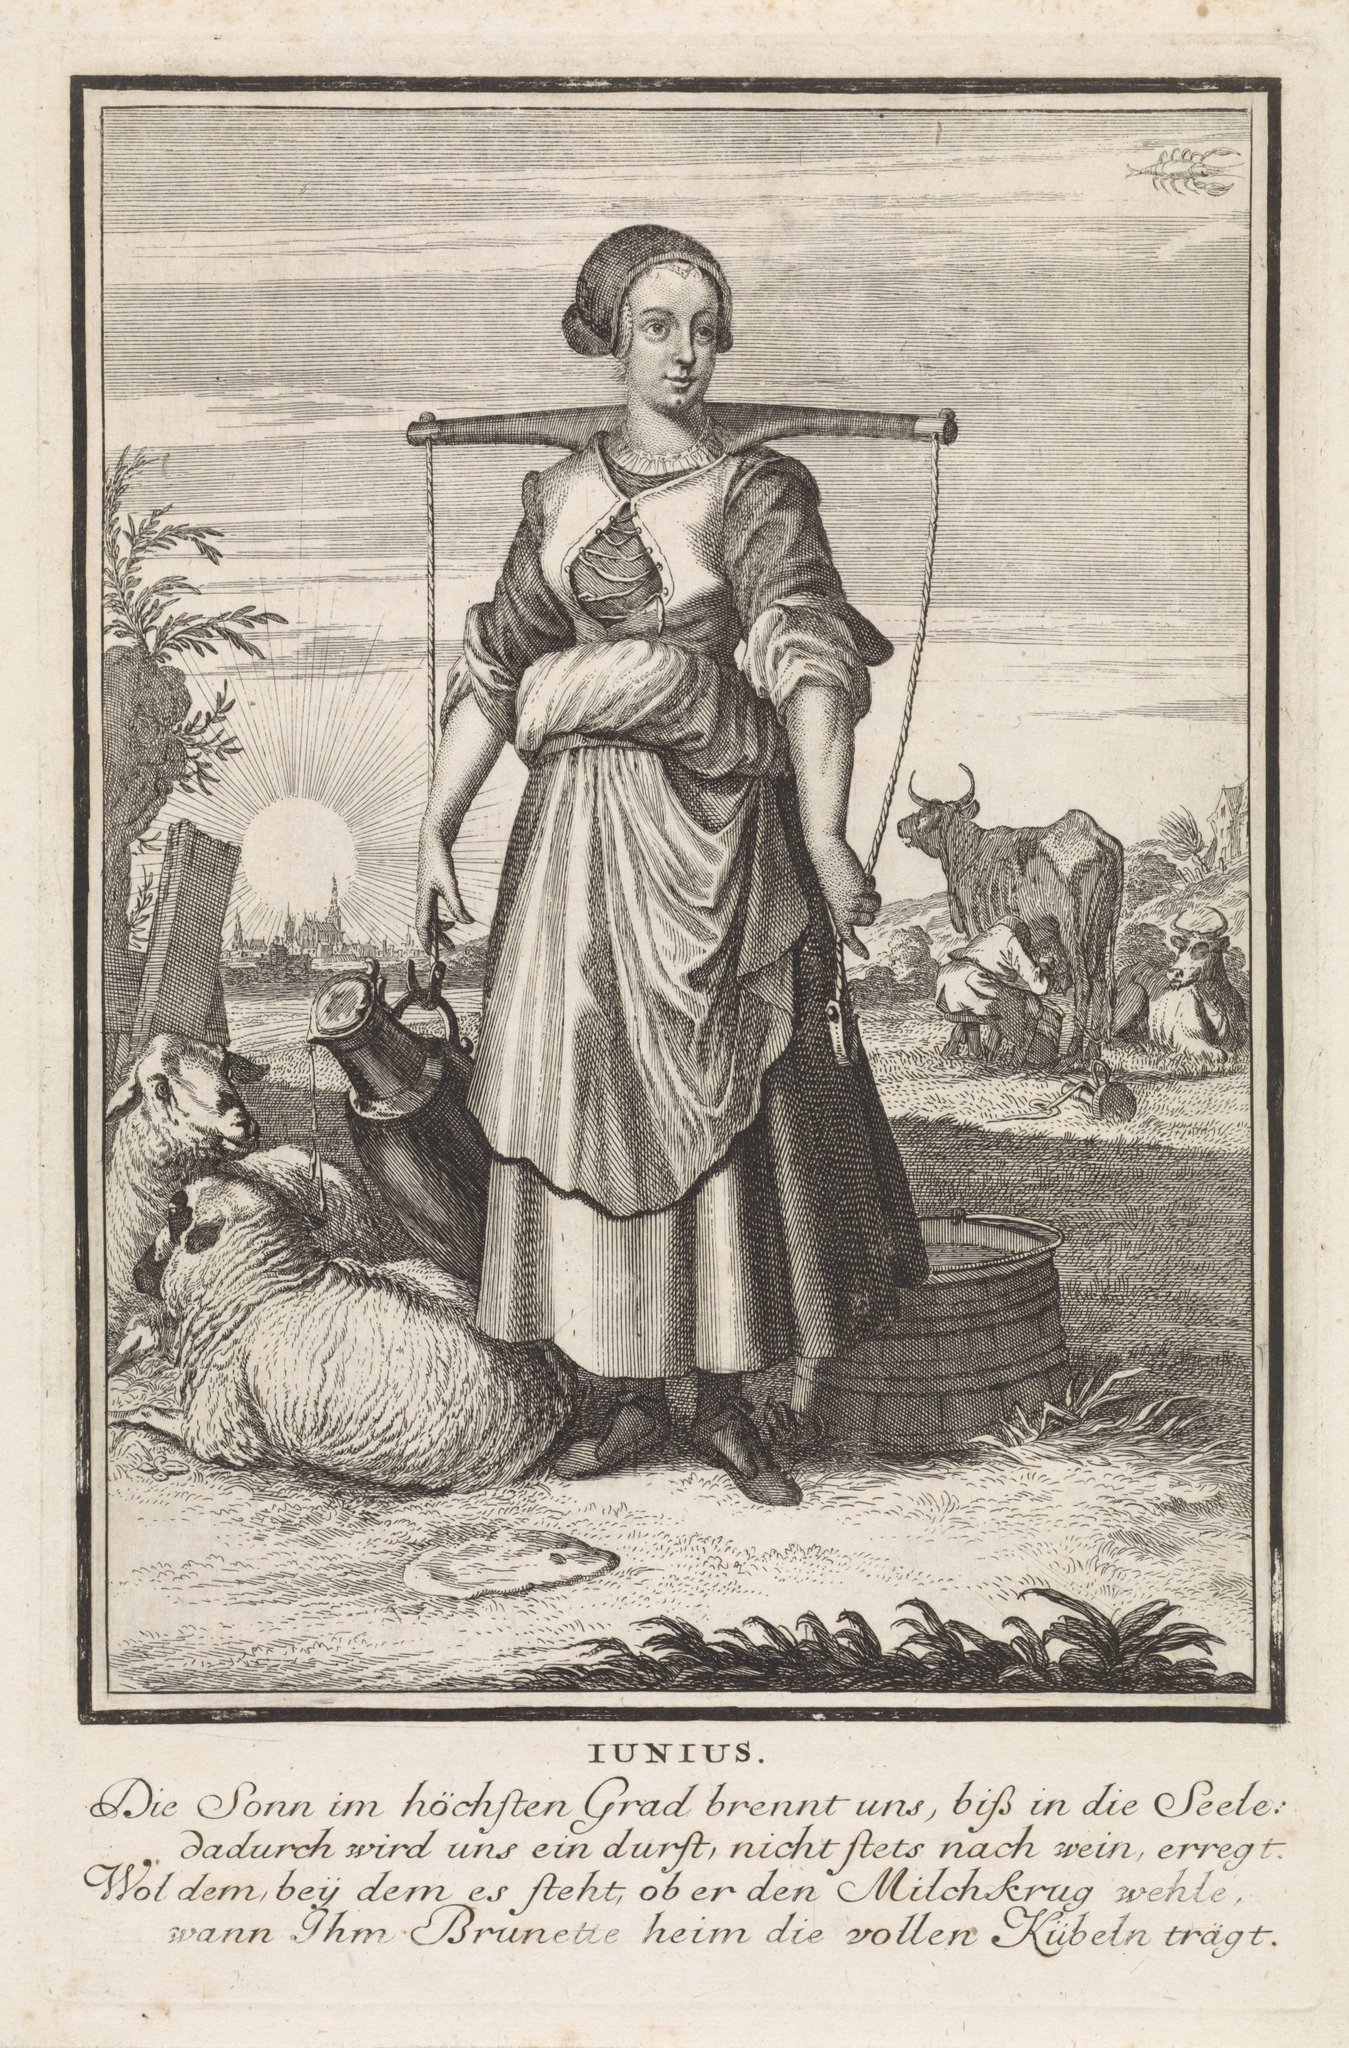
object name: print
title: De twaalf maanden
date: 1698-1702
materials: paper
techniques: engraving, etching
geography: nuremberg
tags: cancer (zodiacal sign of june), landscape symbolizing june, june; 'giugno' (ripa), cow, june and its 'labours', sheep, carrying something with yoke, milkmaid, milking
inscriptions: collector's mark: Lugt 2228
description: De maand juni. Op de voorgrond een melkmeisje naast twee schapen. Ze draagt een juk met een kan melk. Op de achtergrond melkt een boer een koe. De prent heeft een Duits onderschrift van vier regels over de maand juni.